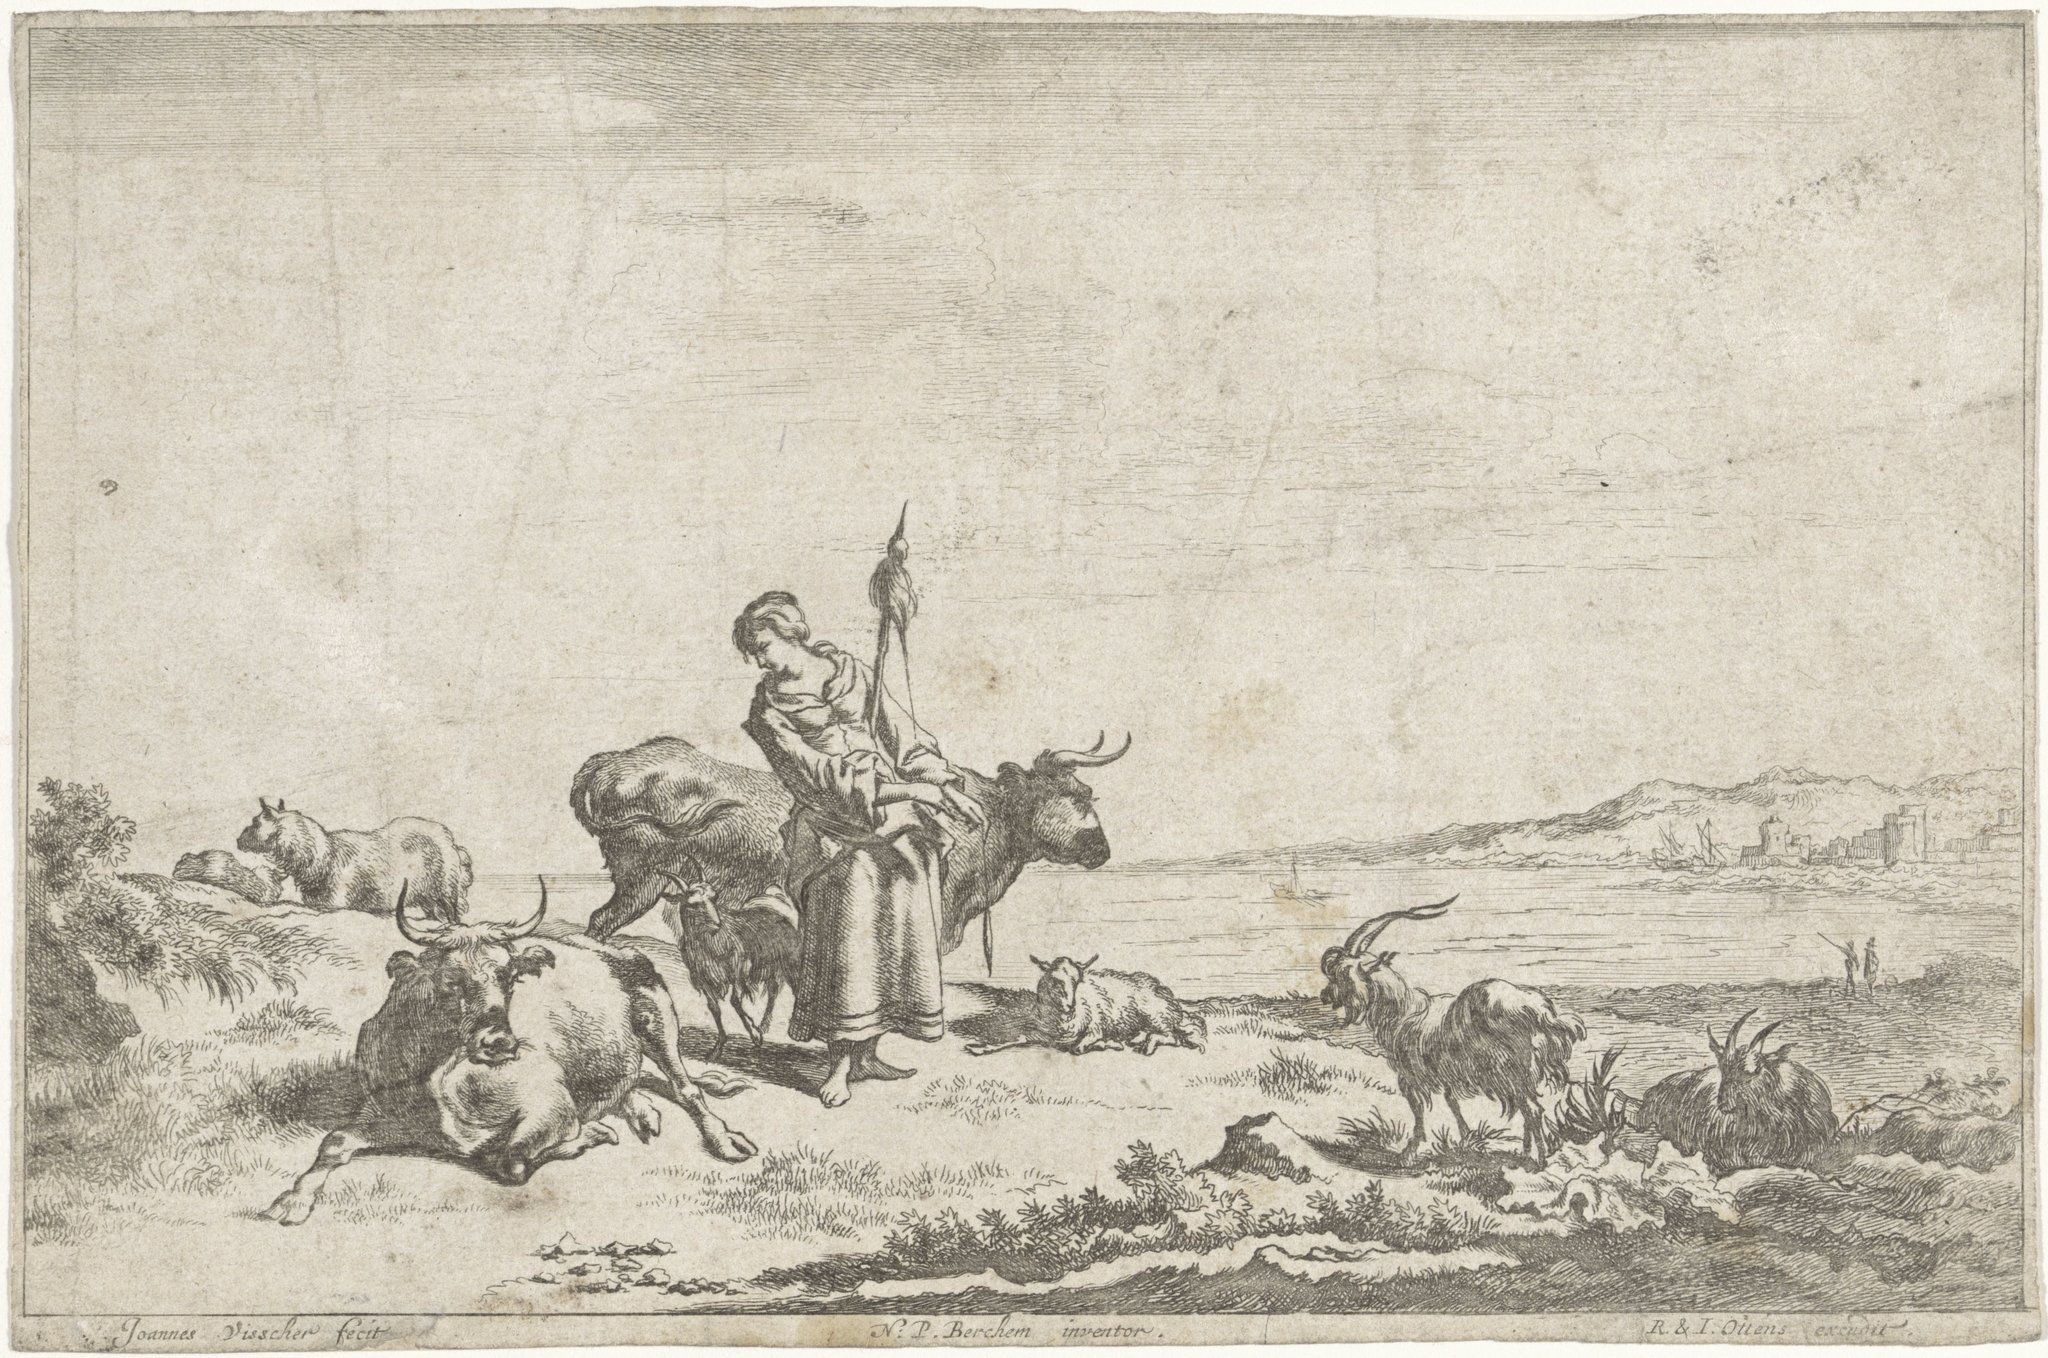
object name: print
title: Herderin met spintol aan de oever van een rivier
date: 1725-1751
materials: paper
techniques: engraving, etching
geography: amsterdam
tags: cow, sailing-ship, sailing-boat, river, herding, herdsman, herdswoman, shepherd, shepherdess, cowherd, etc., spindle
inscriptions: collector's mark: Lugt 2228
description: Aan de oever van een brede rivier staat een herderin met een spintol temidden van het vee. Op de achtergrond een dorp met haven en een schip op de rivier.